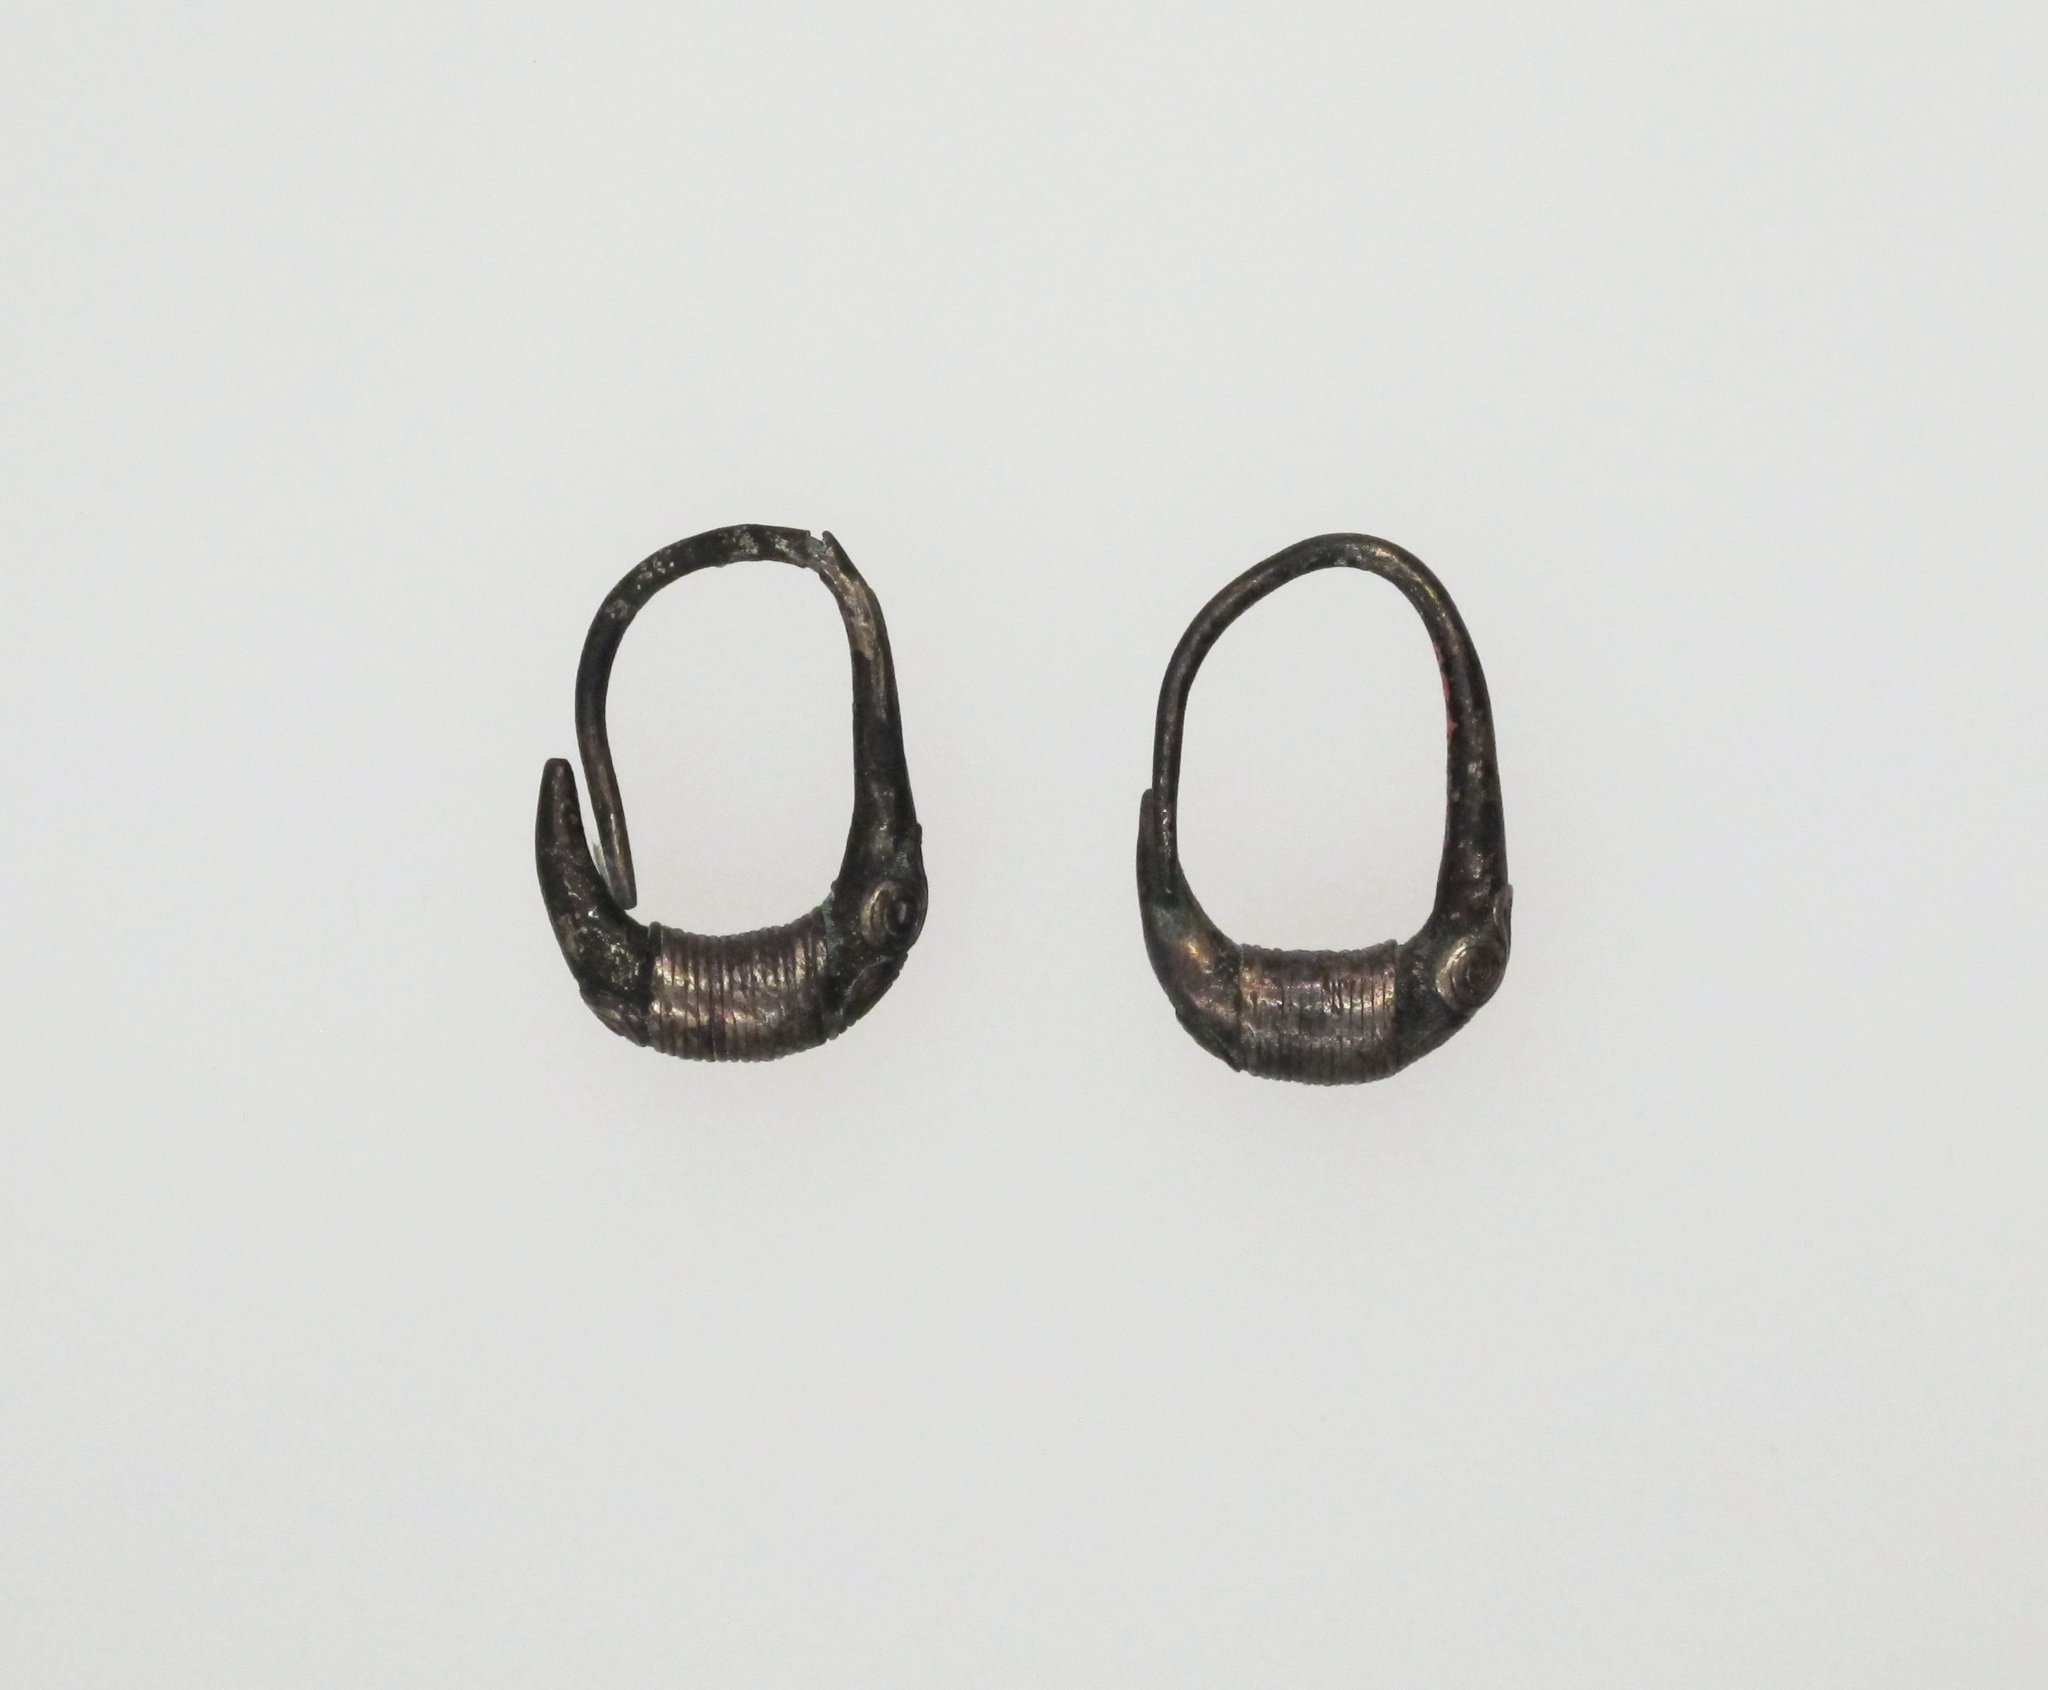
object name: earring, boat shaped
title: Earring, boat-shaped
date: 7000 BCE-330 CE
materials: silver